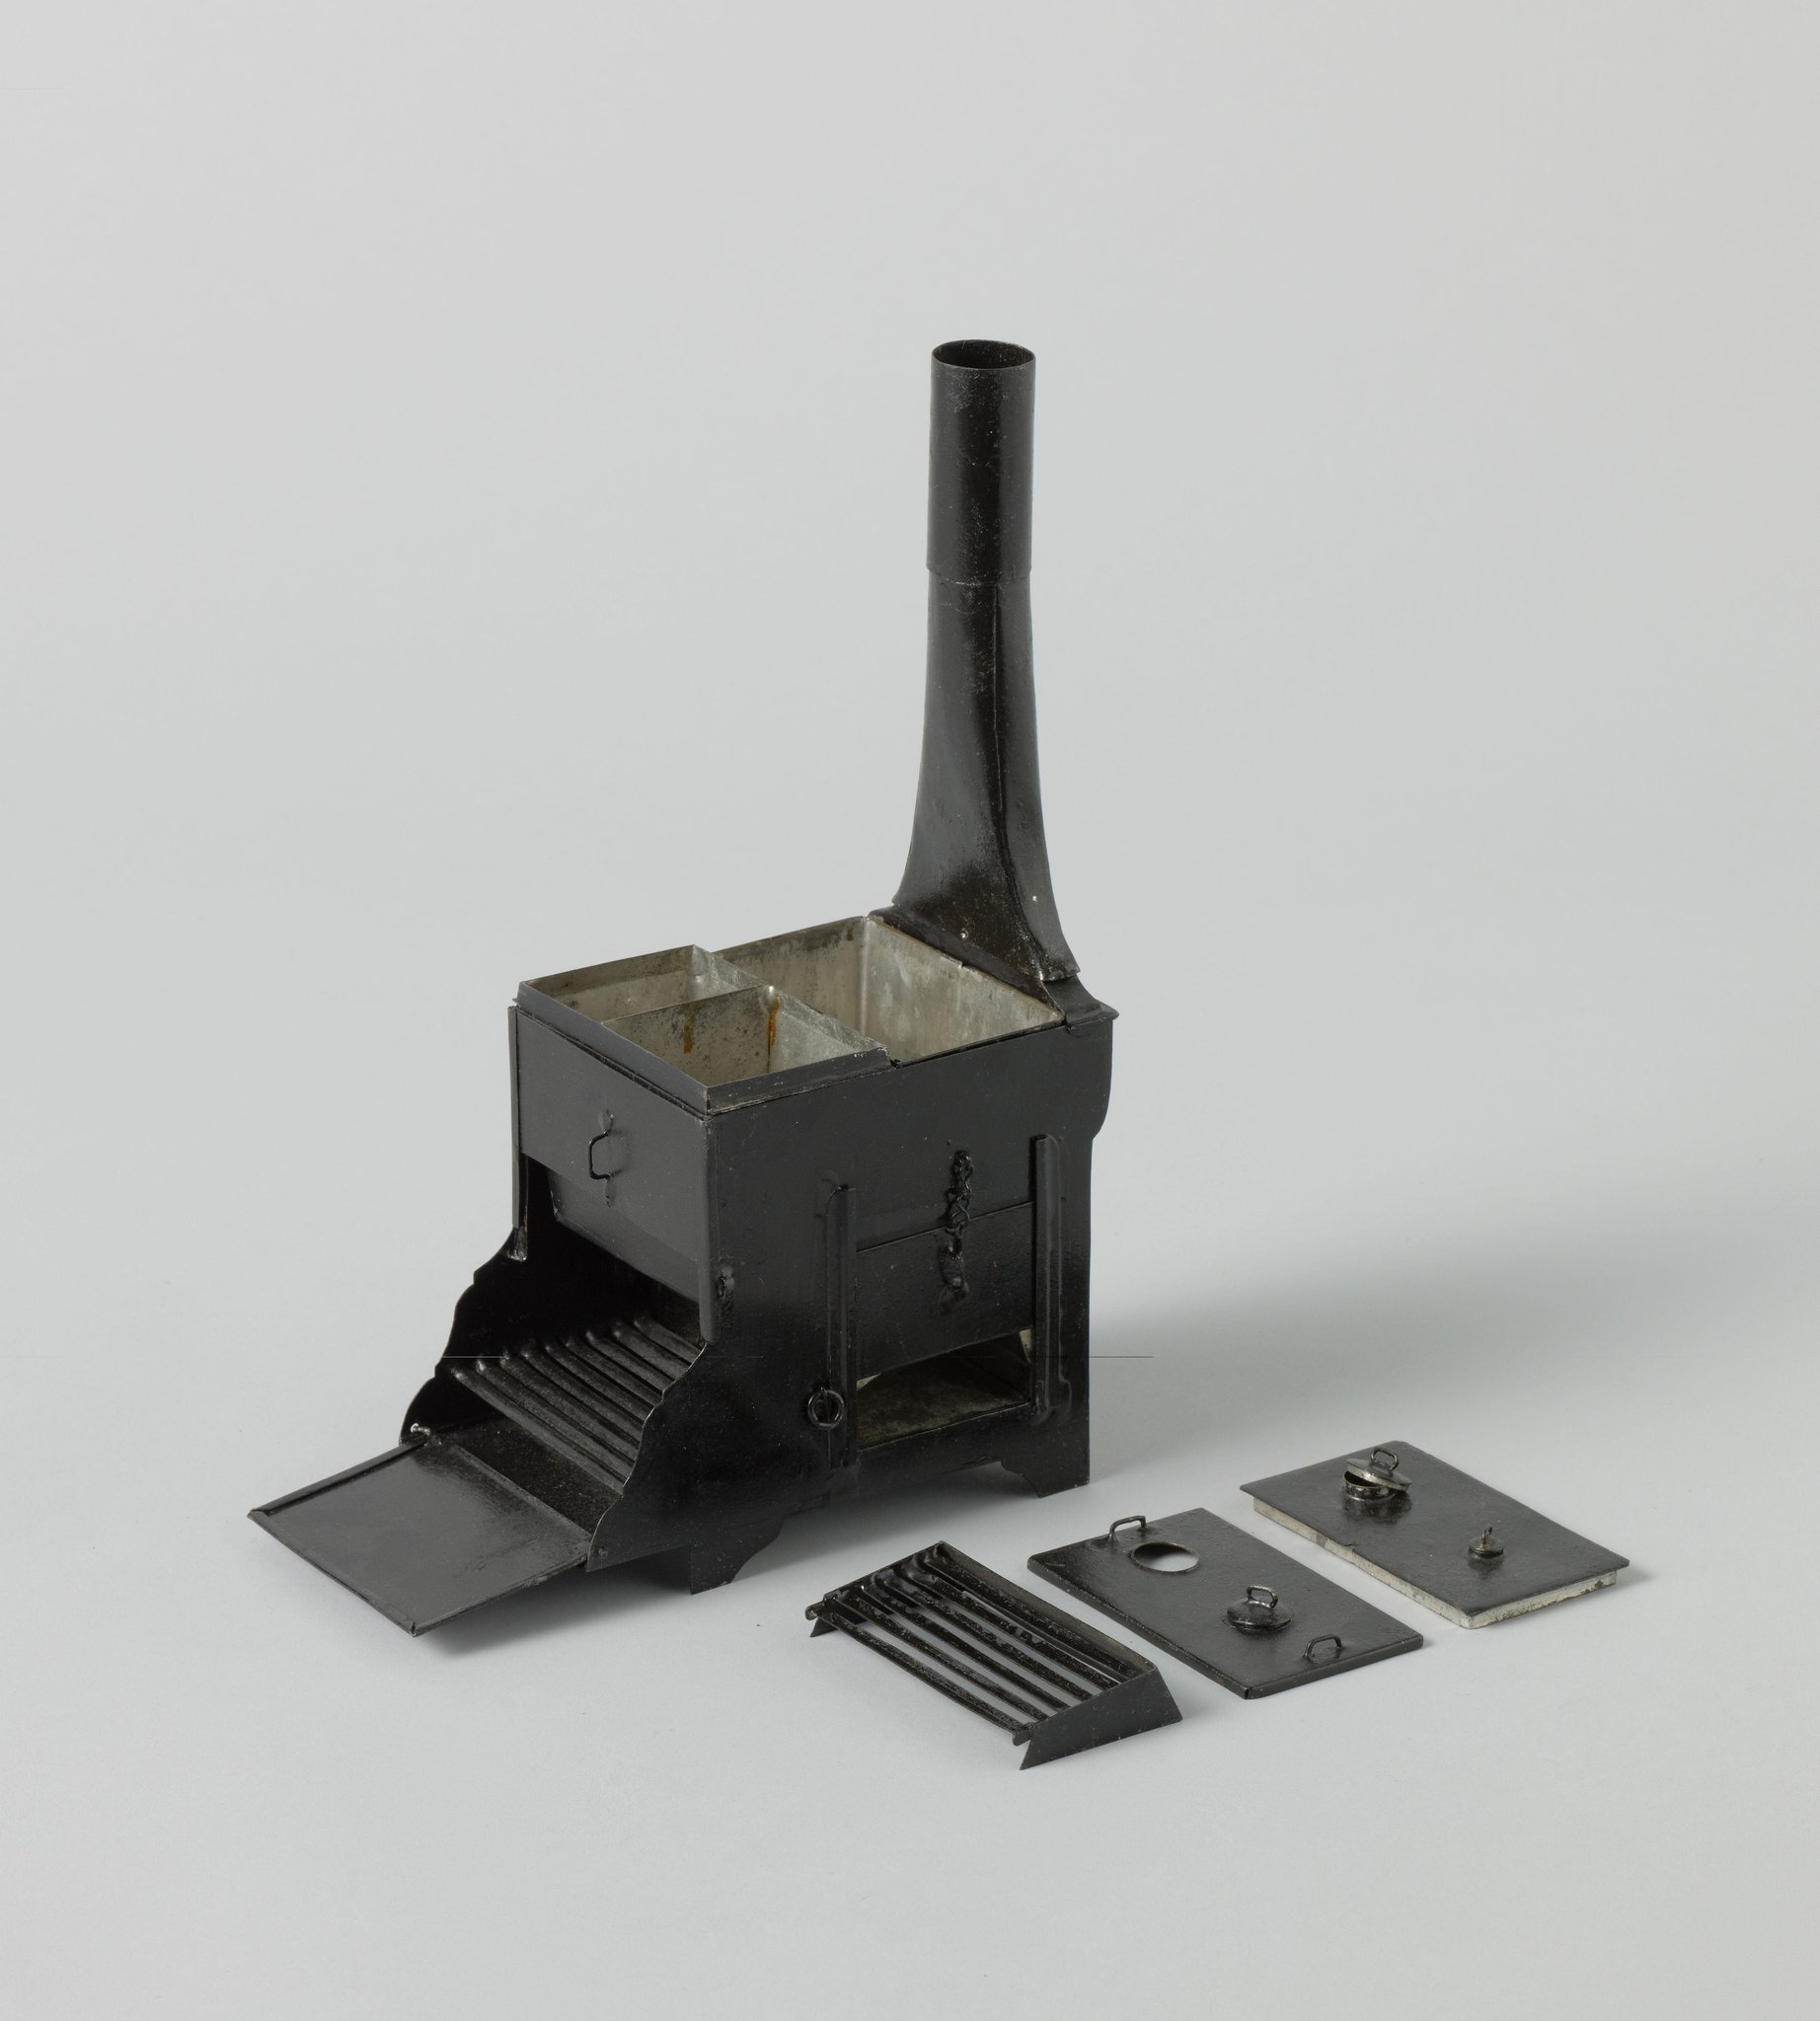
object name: demonstration model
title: Model of a Ship's Galley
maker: Anonymous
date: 1800-1858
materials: iron, paint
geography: netherlands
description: Model van een scheepskombuis, zwart geverfd. Het is een kubusvormig bouwsel met een oven aan de voorkant en een schoorsteen aan de achterkant. Twee bakken, waarvan er een twee compartimenten heeft, hangen bovenin; zij hebben ronde openingen bovenin. Een apart compartiment, waarin langs een opening in de zijkant een rooster geschoven kan worden, is binnen in de oven gebouwd zodat de hete gassen er helemaal omheen kunnen.